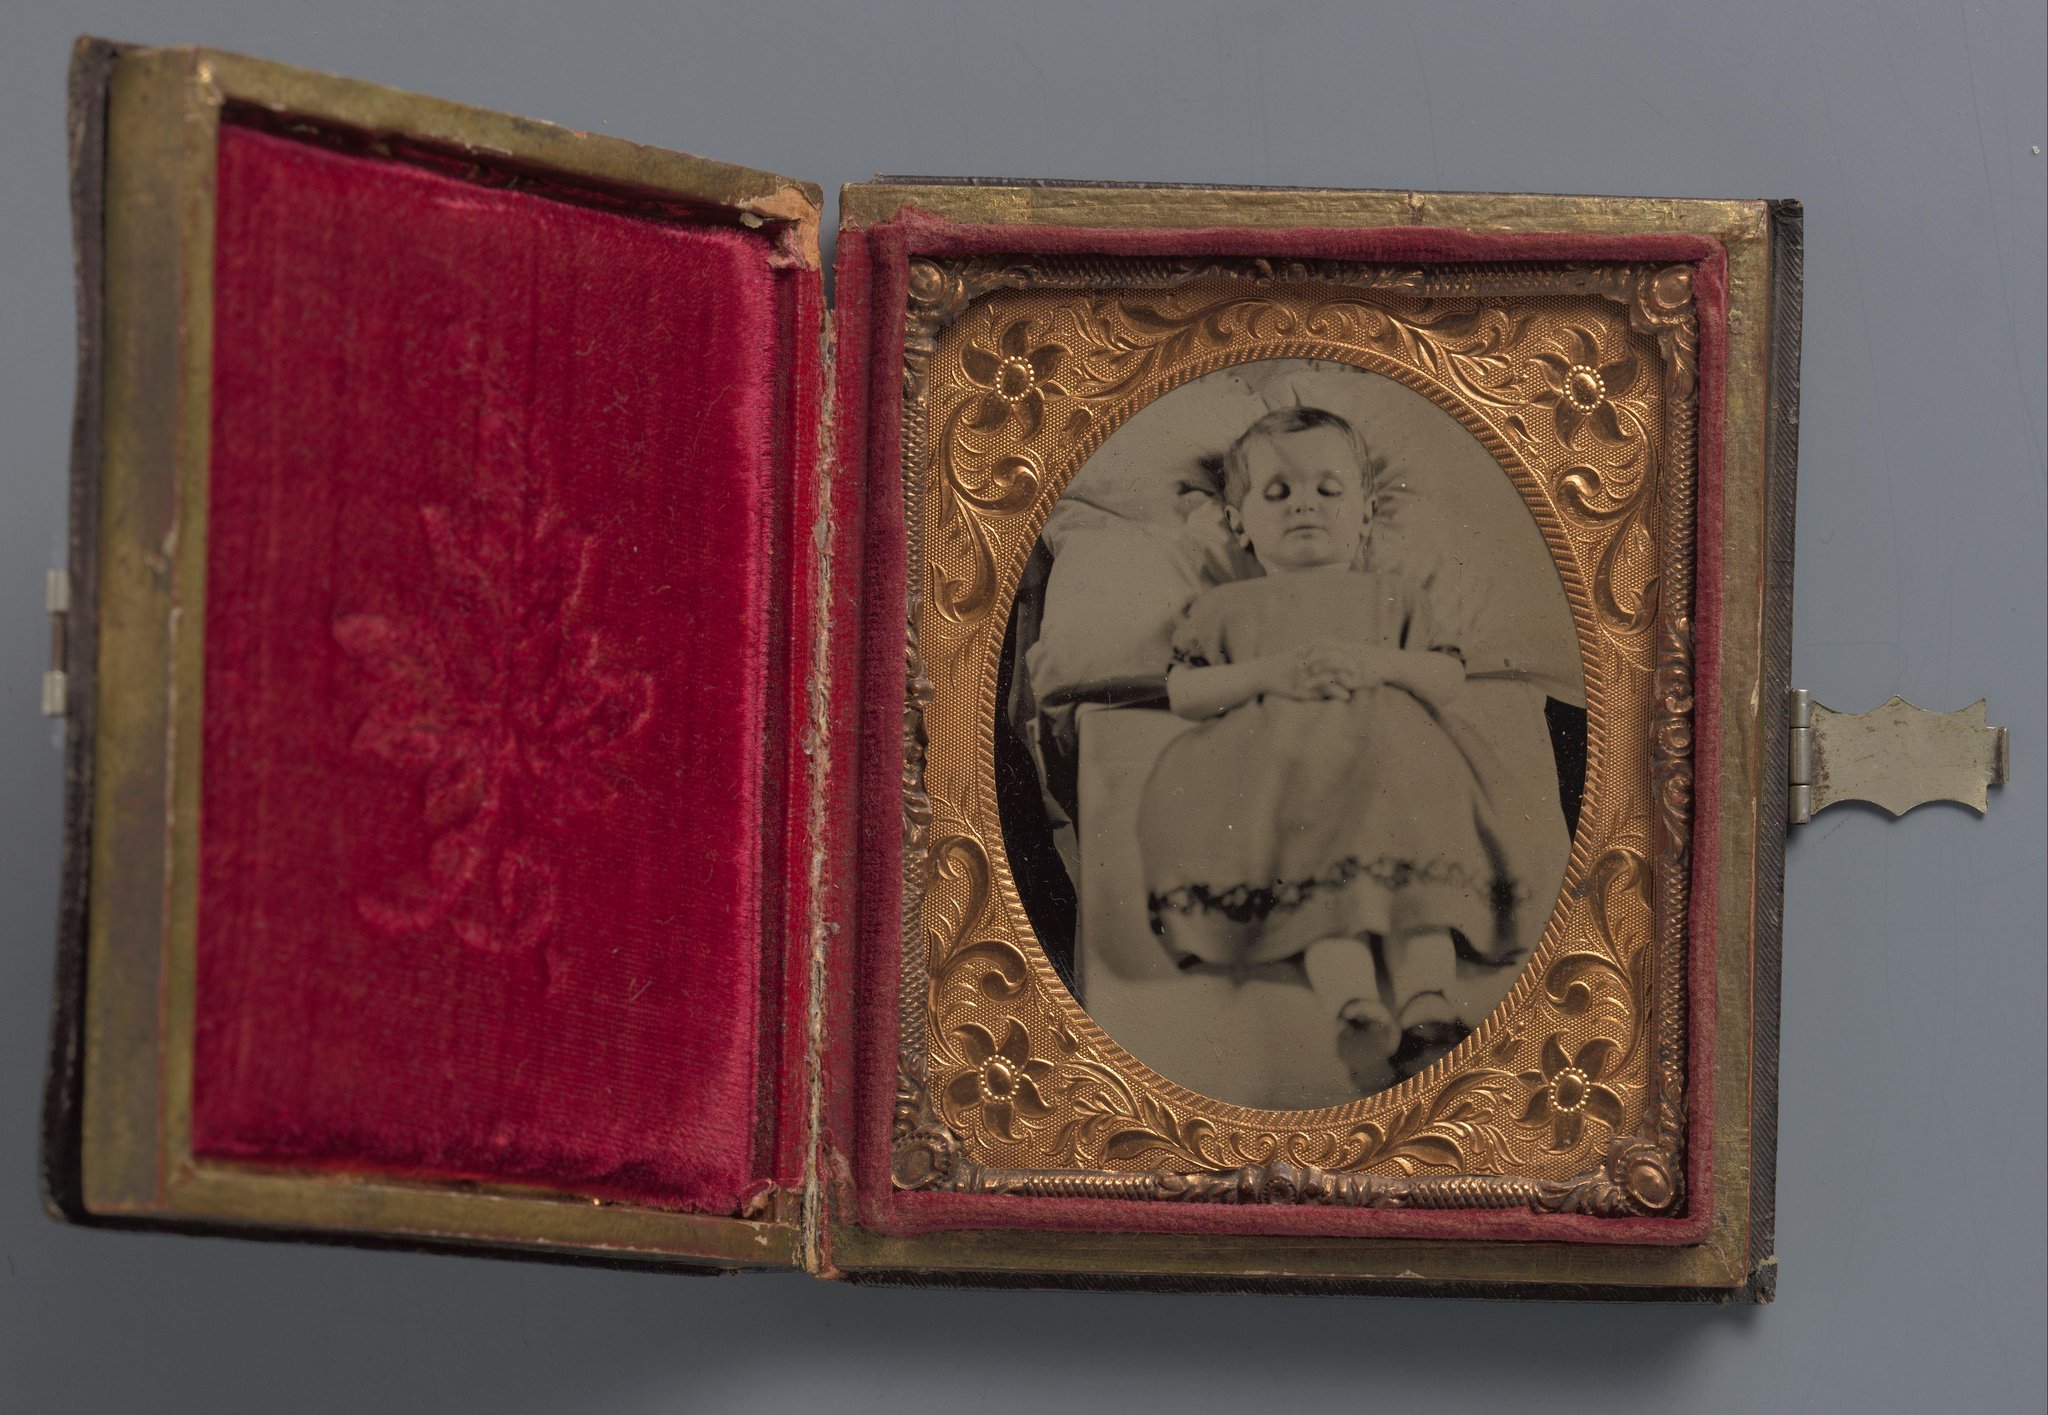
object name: photograph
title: Post-mortemportret van een onbekend kind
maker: Anonymous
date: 1855-1900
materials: cardboard, glass, iron, metal, paper, textile, wood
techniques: ferrotyping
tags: child, the corpse